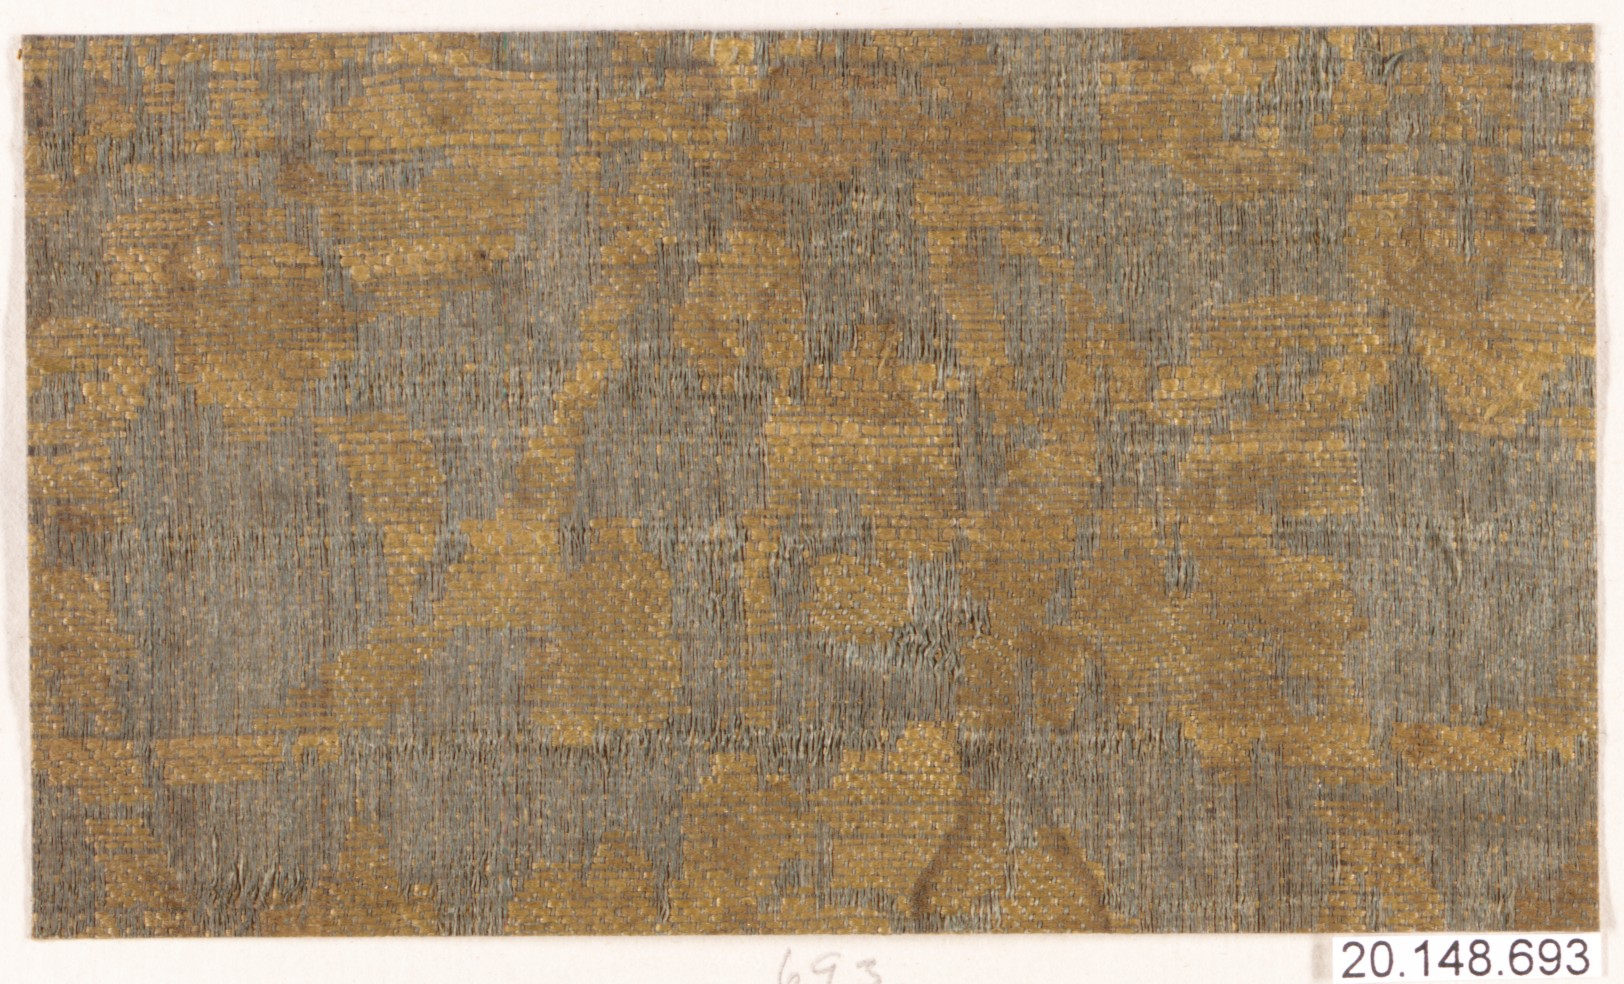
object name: piece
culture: japanese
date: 1801-1900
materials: silk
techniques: compound weave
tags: leaves